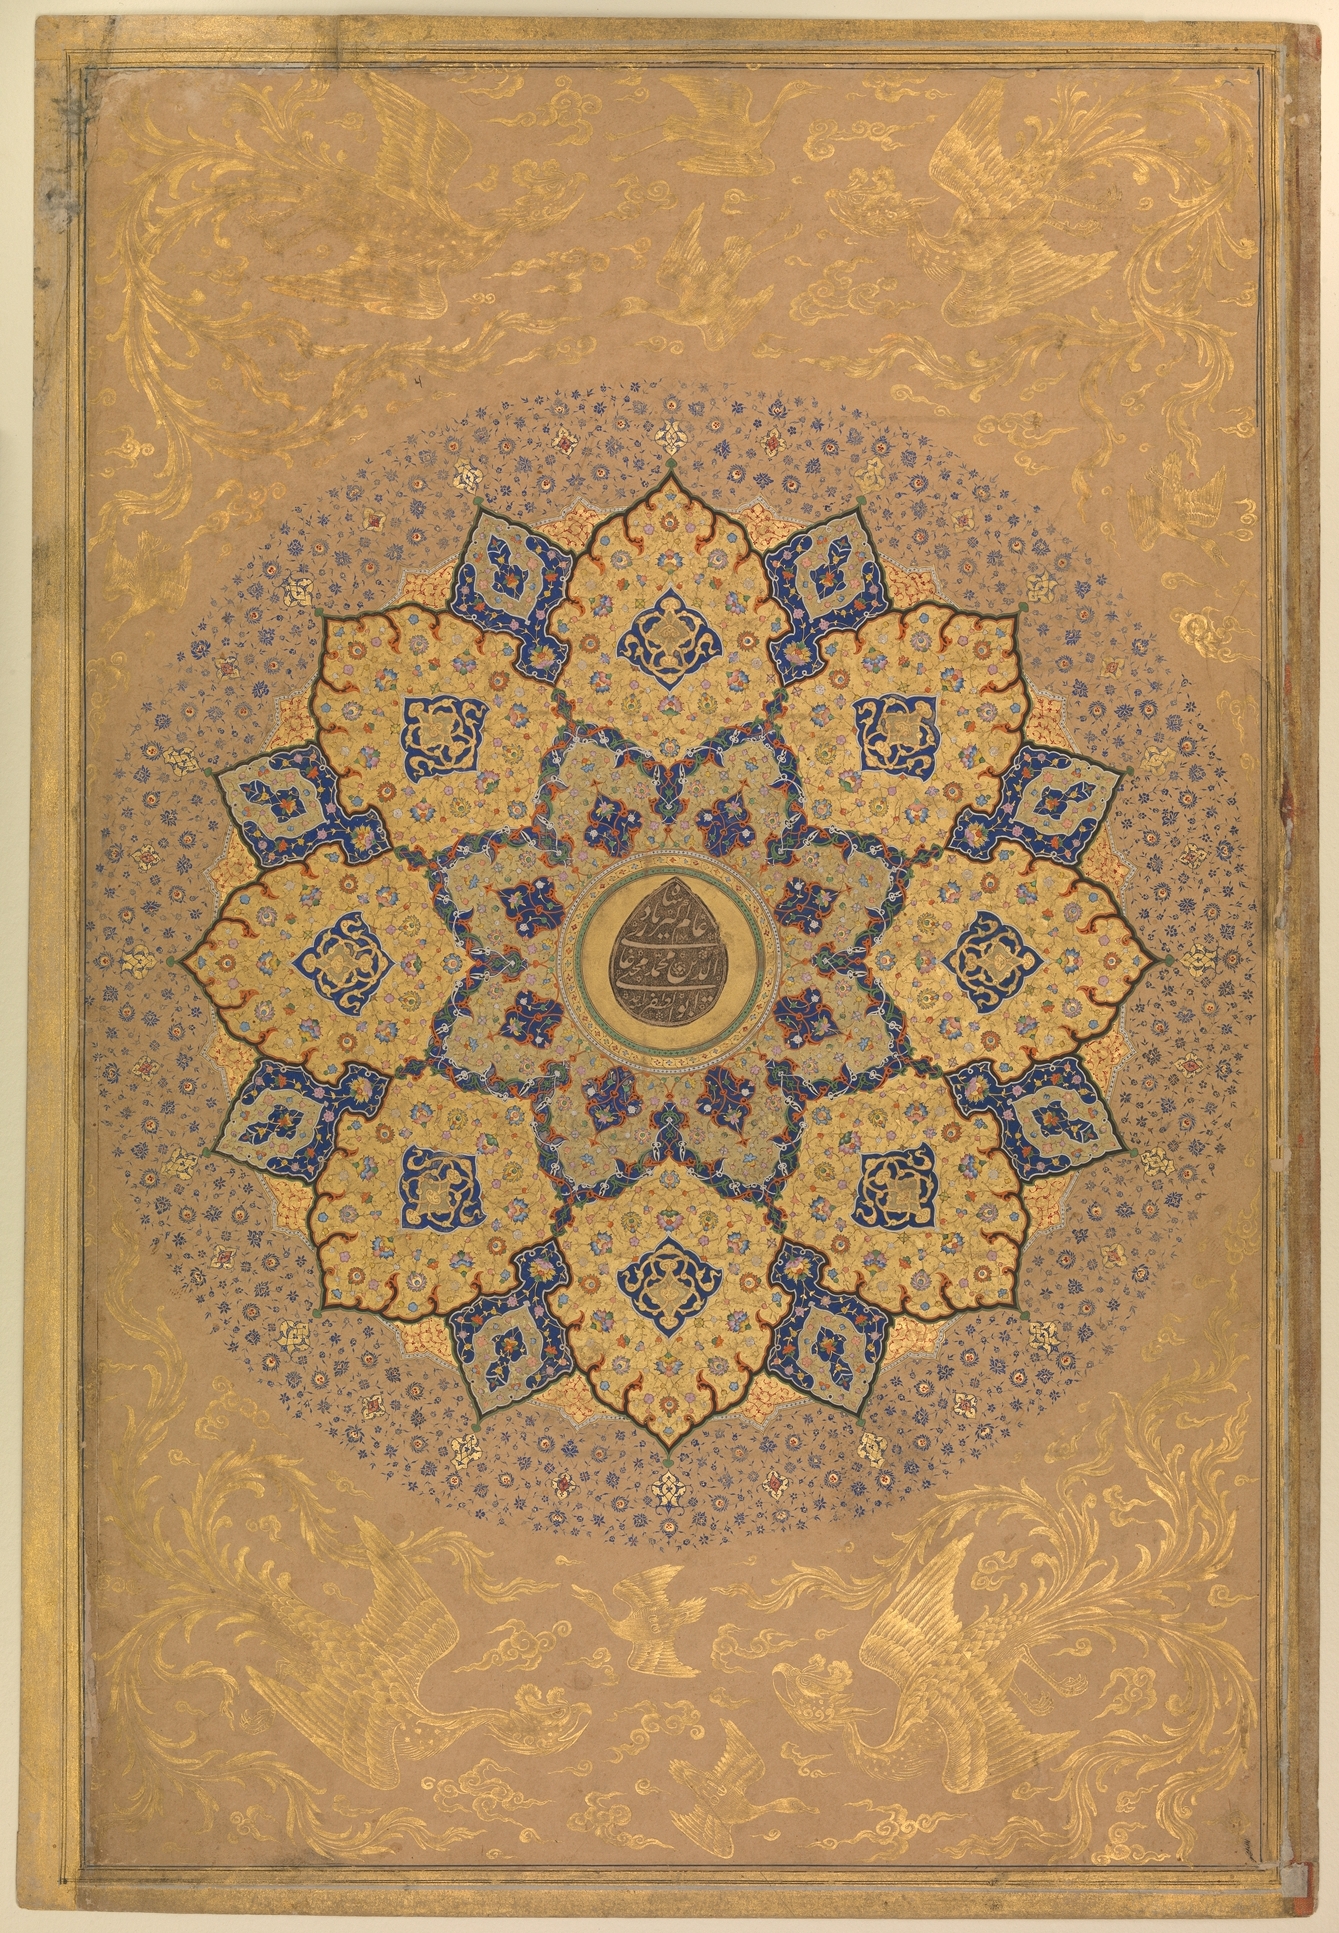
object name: non illustrated album leaf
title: Rosette Bearing the Name and Title of Emperor Aurangzeb (Recto), from the Shah Jahan Album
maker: mir 'ali haravi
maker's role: calligrapher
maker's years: 1525-1575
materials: gold, ink, paper, watercolor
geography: india